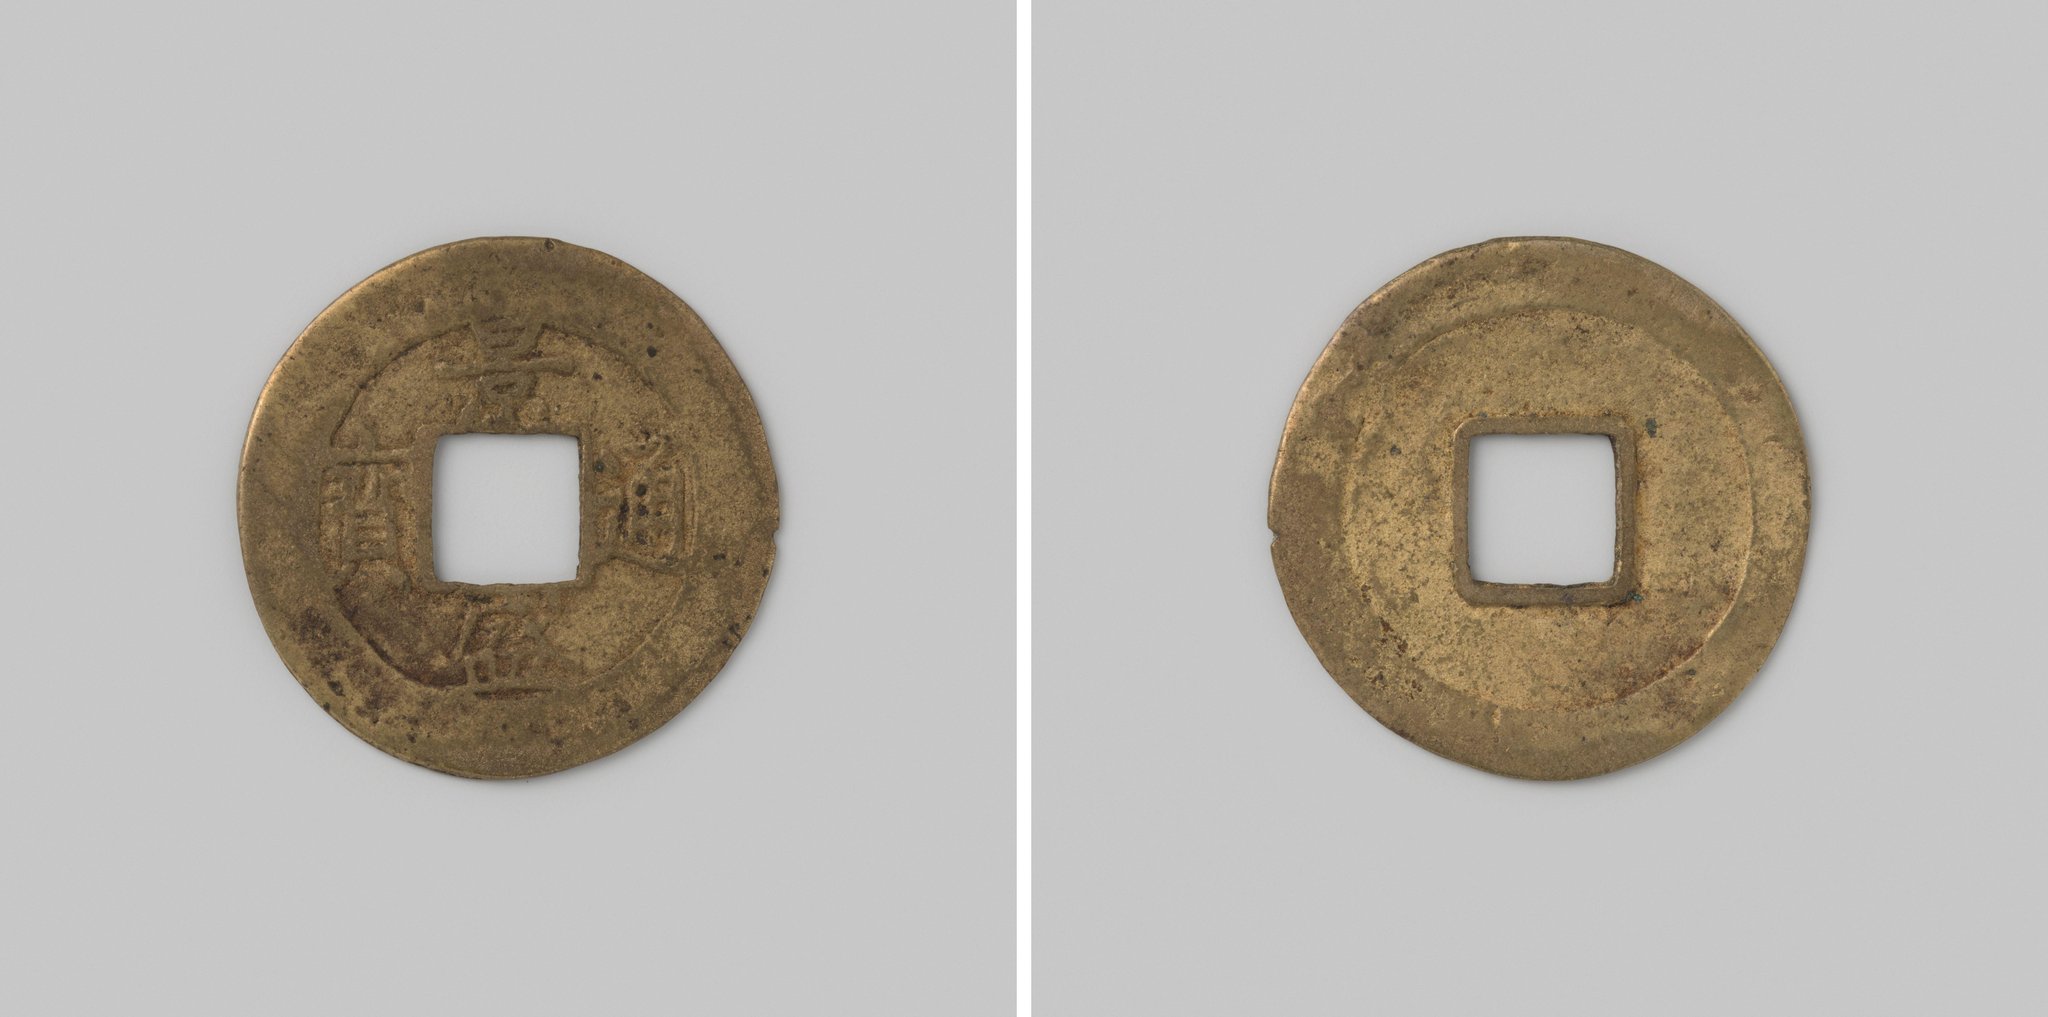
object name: coin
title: Tsjien of donga uit het keizerrijk Annam van opstandeling Nguyen Van-toan, 1792-1801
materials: copper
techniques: striking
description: Koperen munt. Voorzijde: vier Chinese karakters rondom vierkante uitsparing in het midden. Keerzijde: glad.